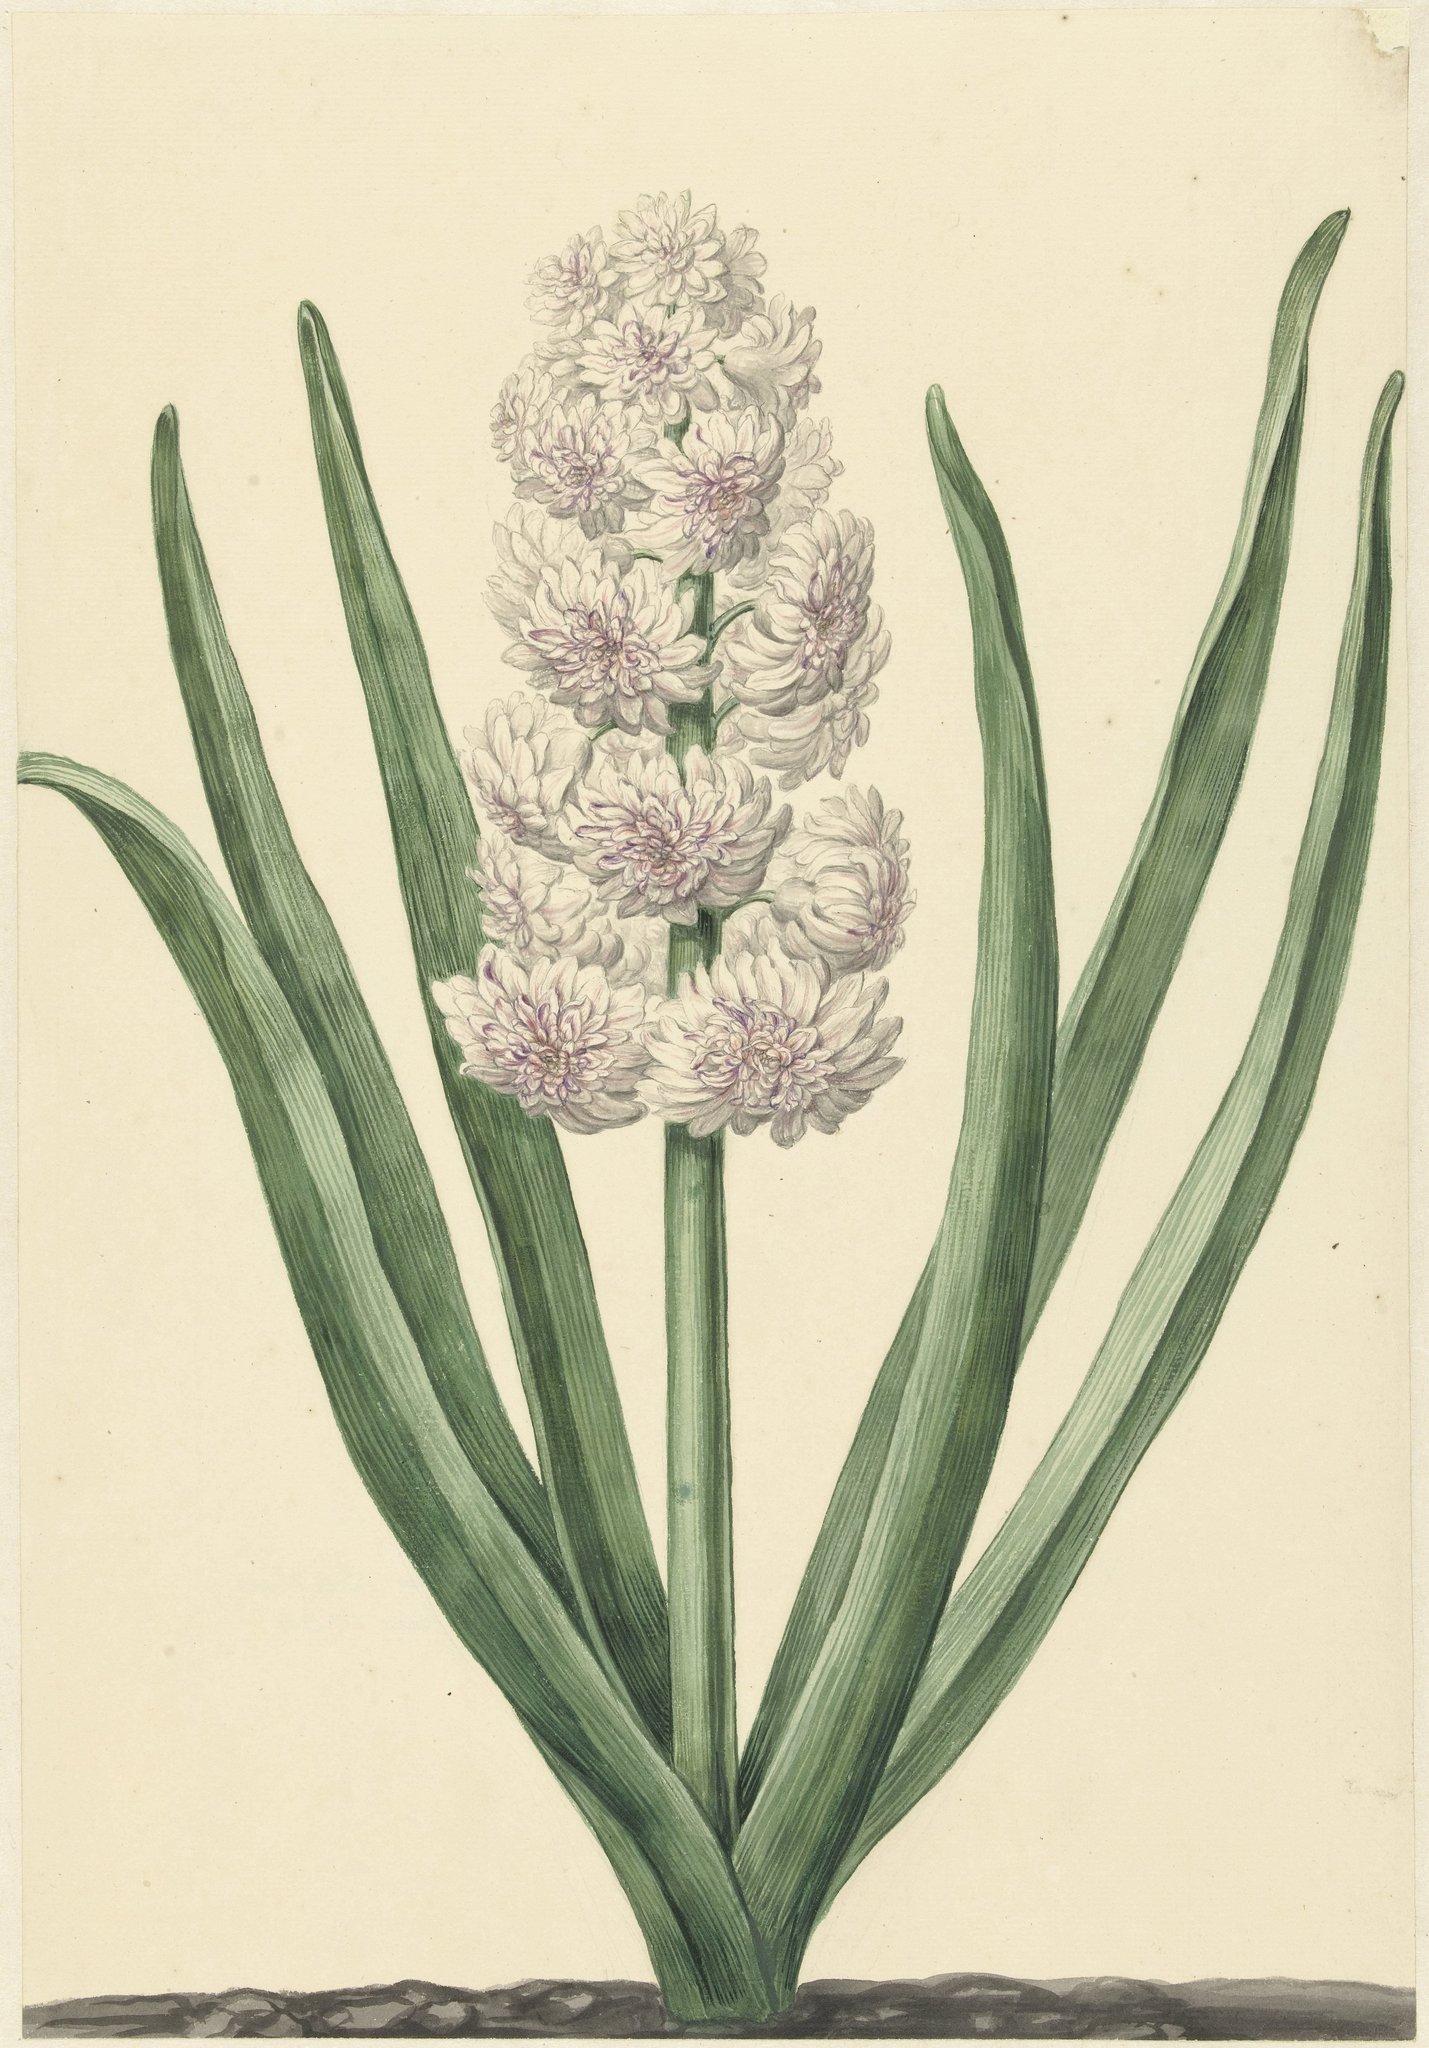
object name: drawing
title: De rozewitte hyacint Staaten Generaal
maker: abraham hendrik van beesten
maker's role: draughtsman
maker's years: 1696-1773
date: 1734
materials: ink, paper, pencil, watercolor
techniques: brush, pen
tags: flowers: hyacinth